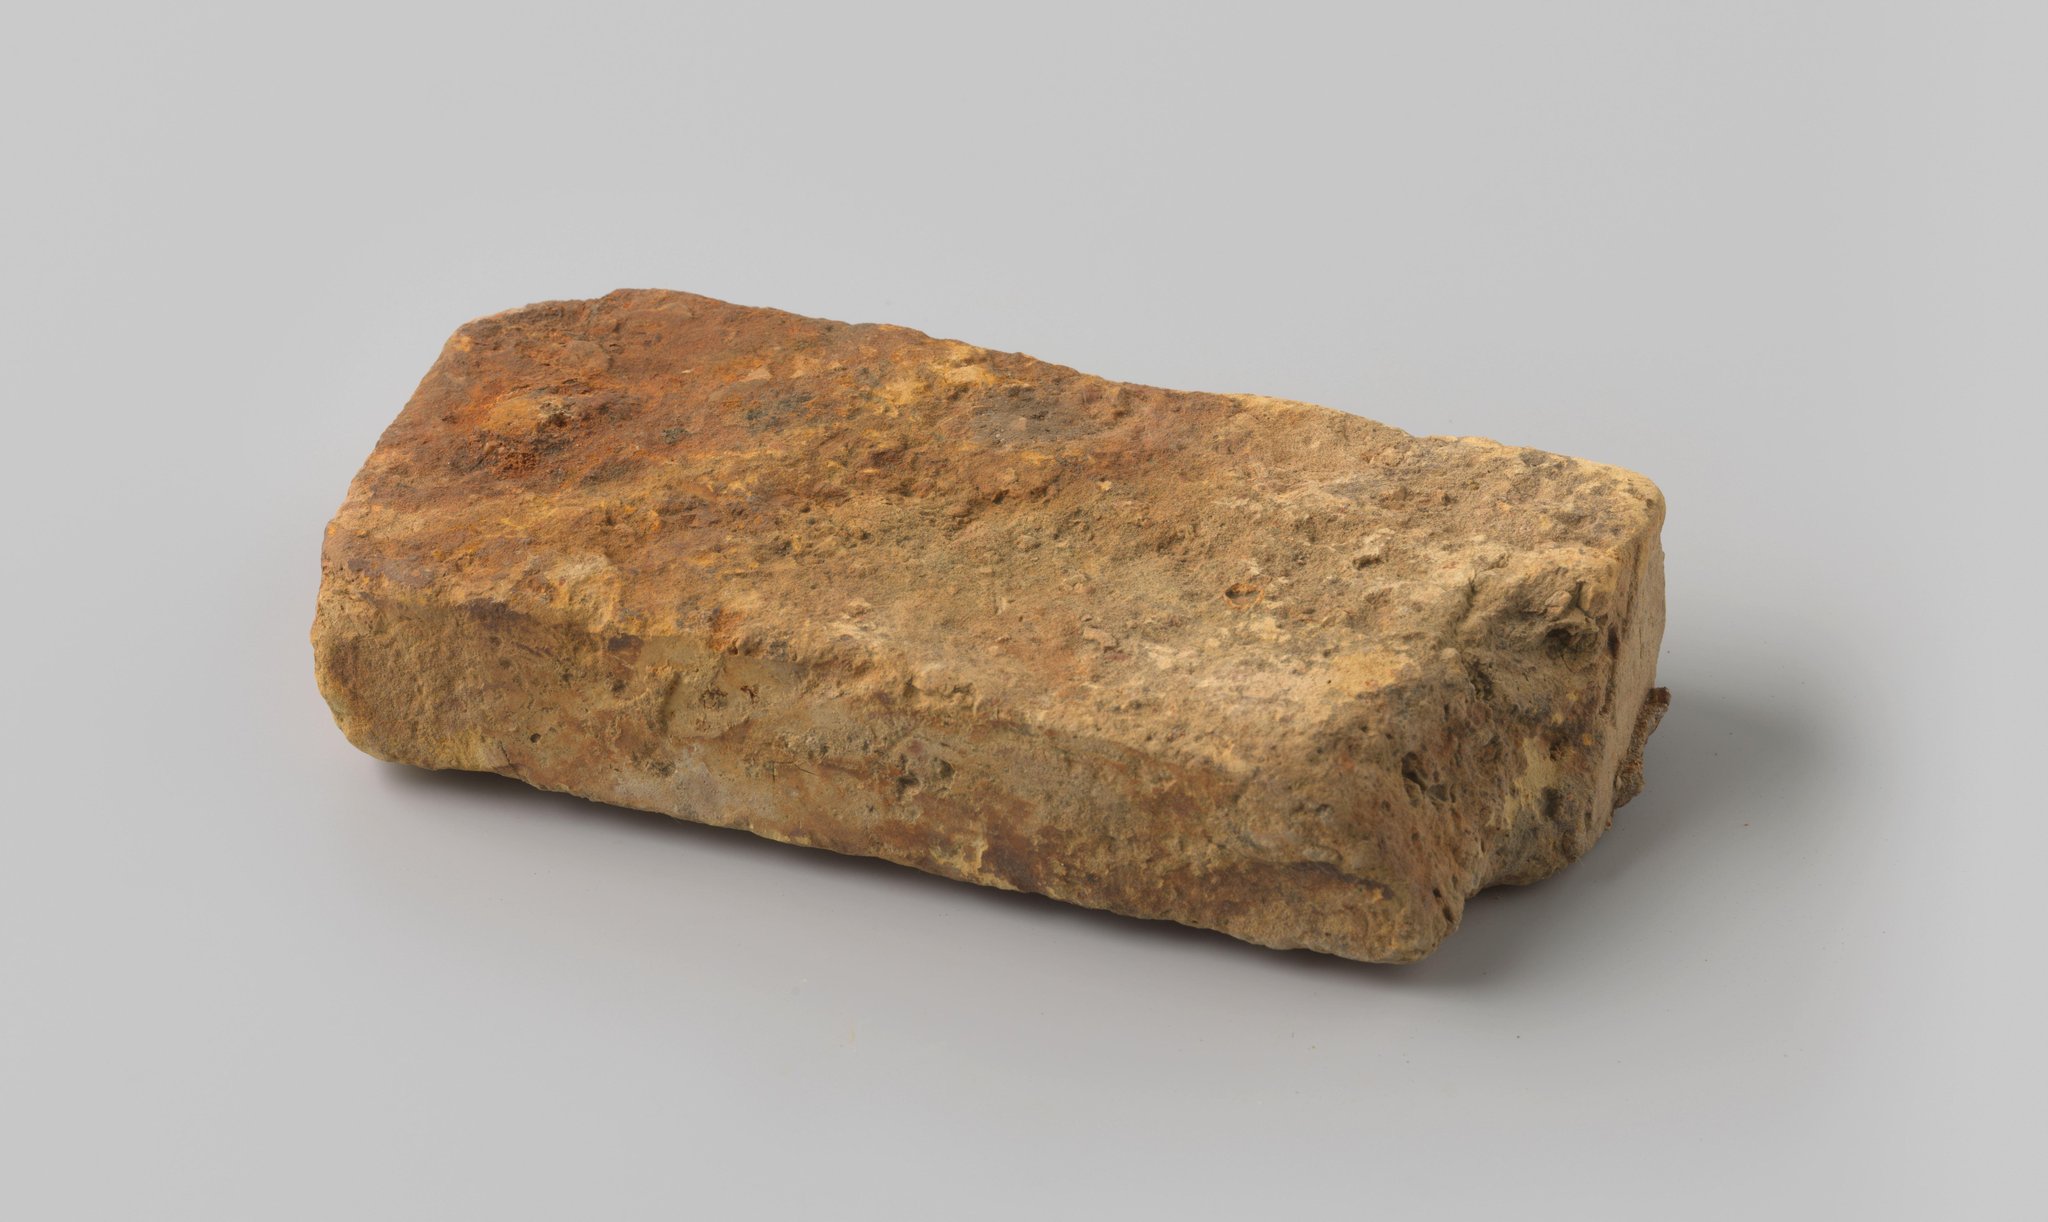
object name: brick clay product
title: Baksteen uit het wrak van de Oost-Indiëvaarder Hollandia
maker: Anonymous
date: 1700-1743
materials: brick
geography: netherlands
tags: verenigde oostindische compagnie, hollandia (schip), annet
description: Constructional elements, brick; sim. 80H2567, sim. 80H1208, sim. 80H1009.